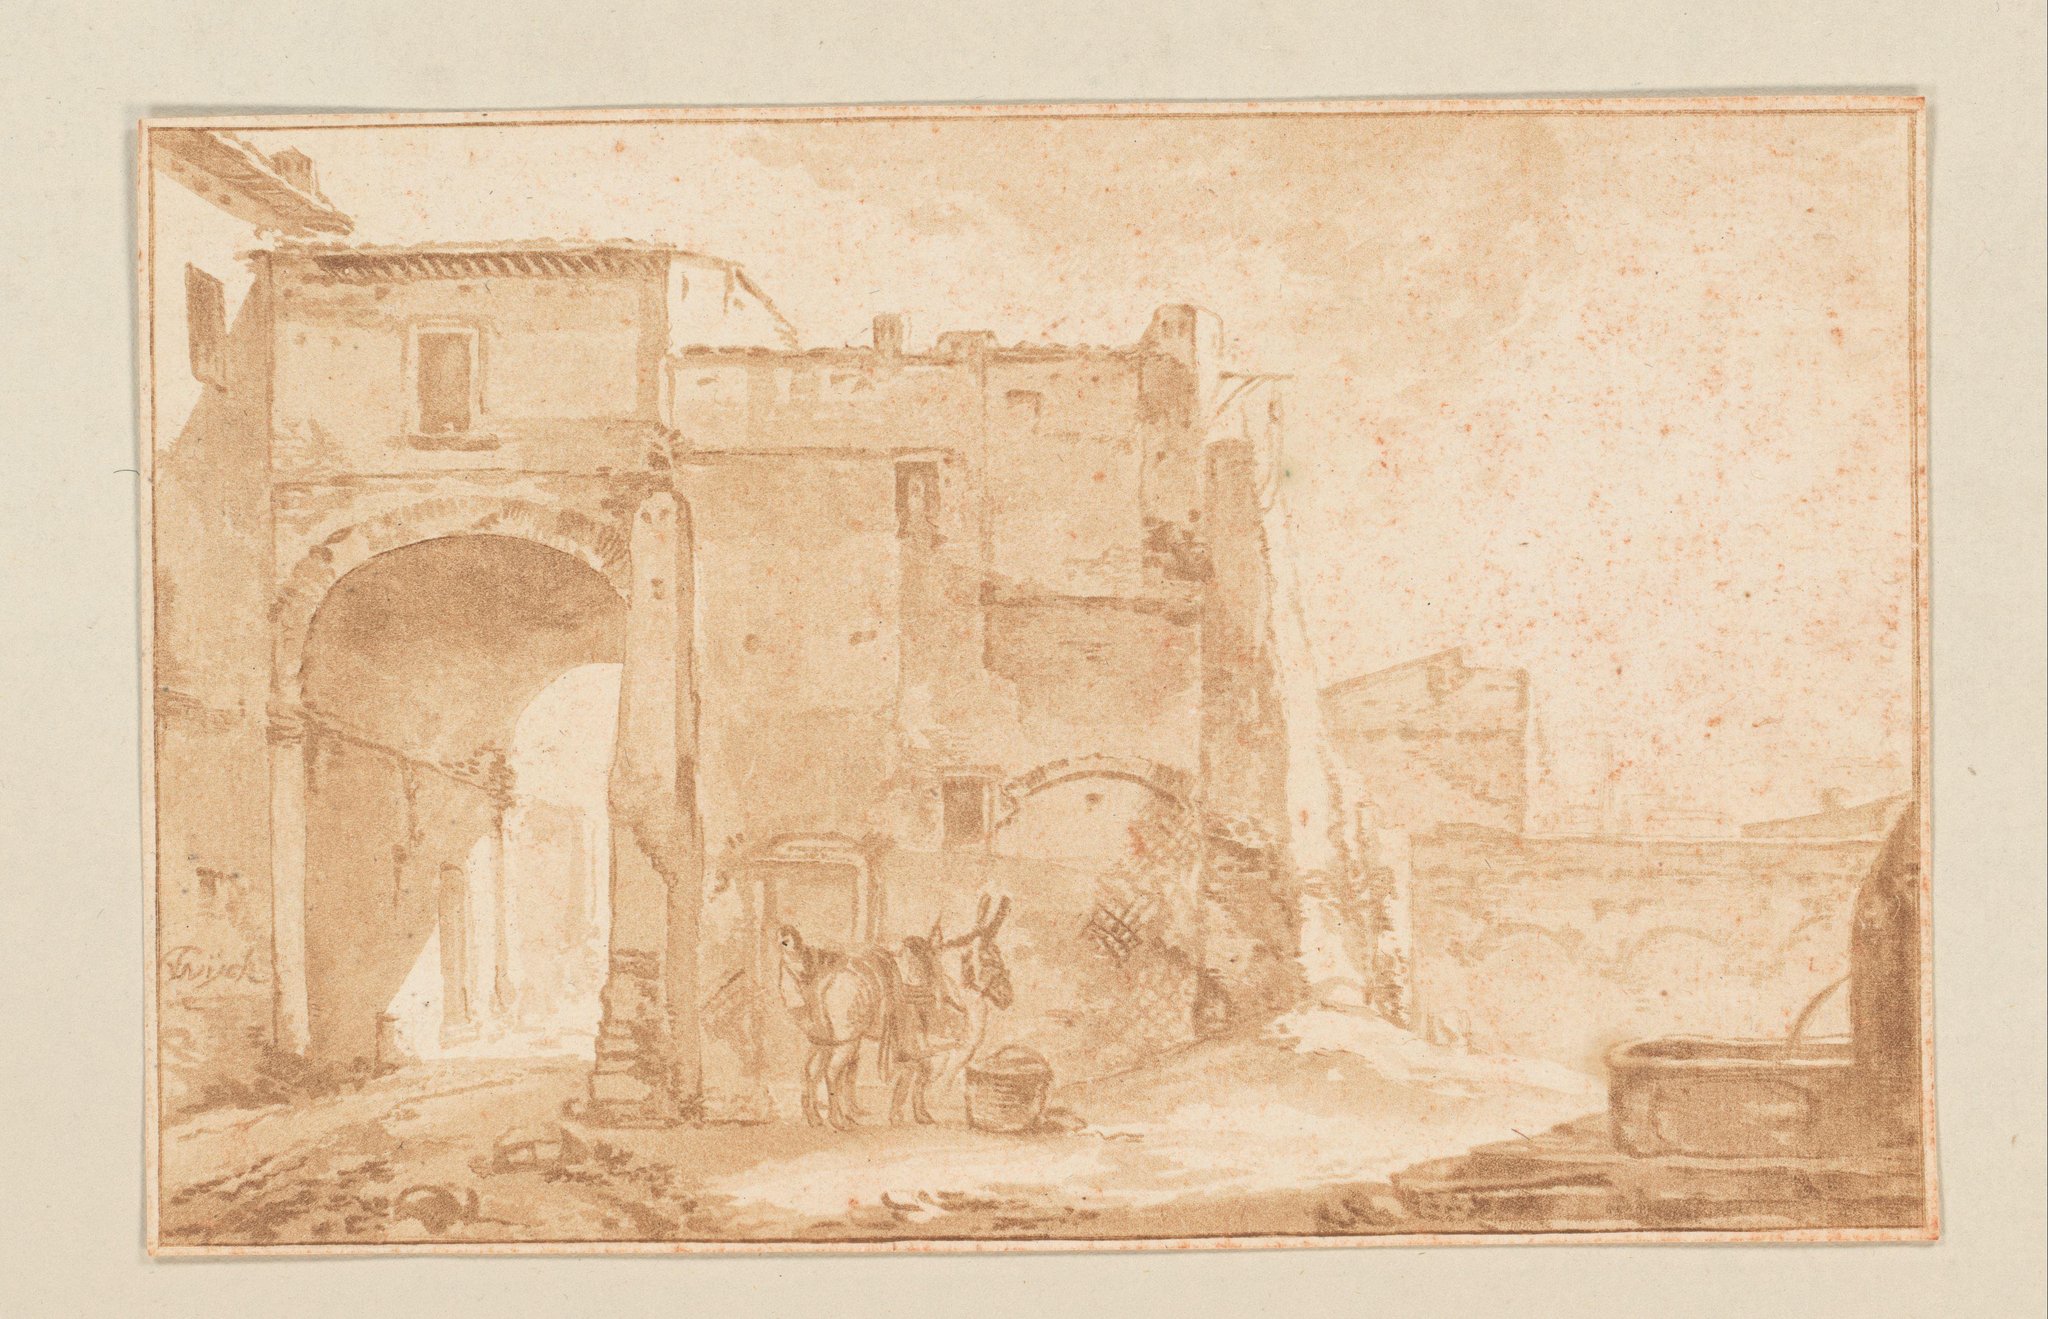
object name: maculature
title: Poort met reiziger en muildier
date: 1781-1782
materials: paper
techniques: etching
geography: amsterdam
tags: city-view, and landscape with man-made constructions, mule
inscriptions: collector's mark: ‘RIJKS / MUSM’, collector's mark: Lugt 2725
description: Bij een poort staan een man en een muildier. Rechts een waterbron. De prent ligt los in een album, zie blad 35.